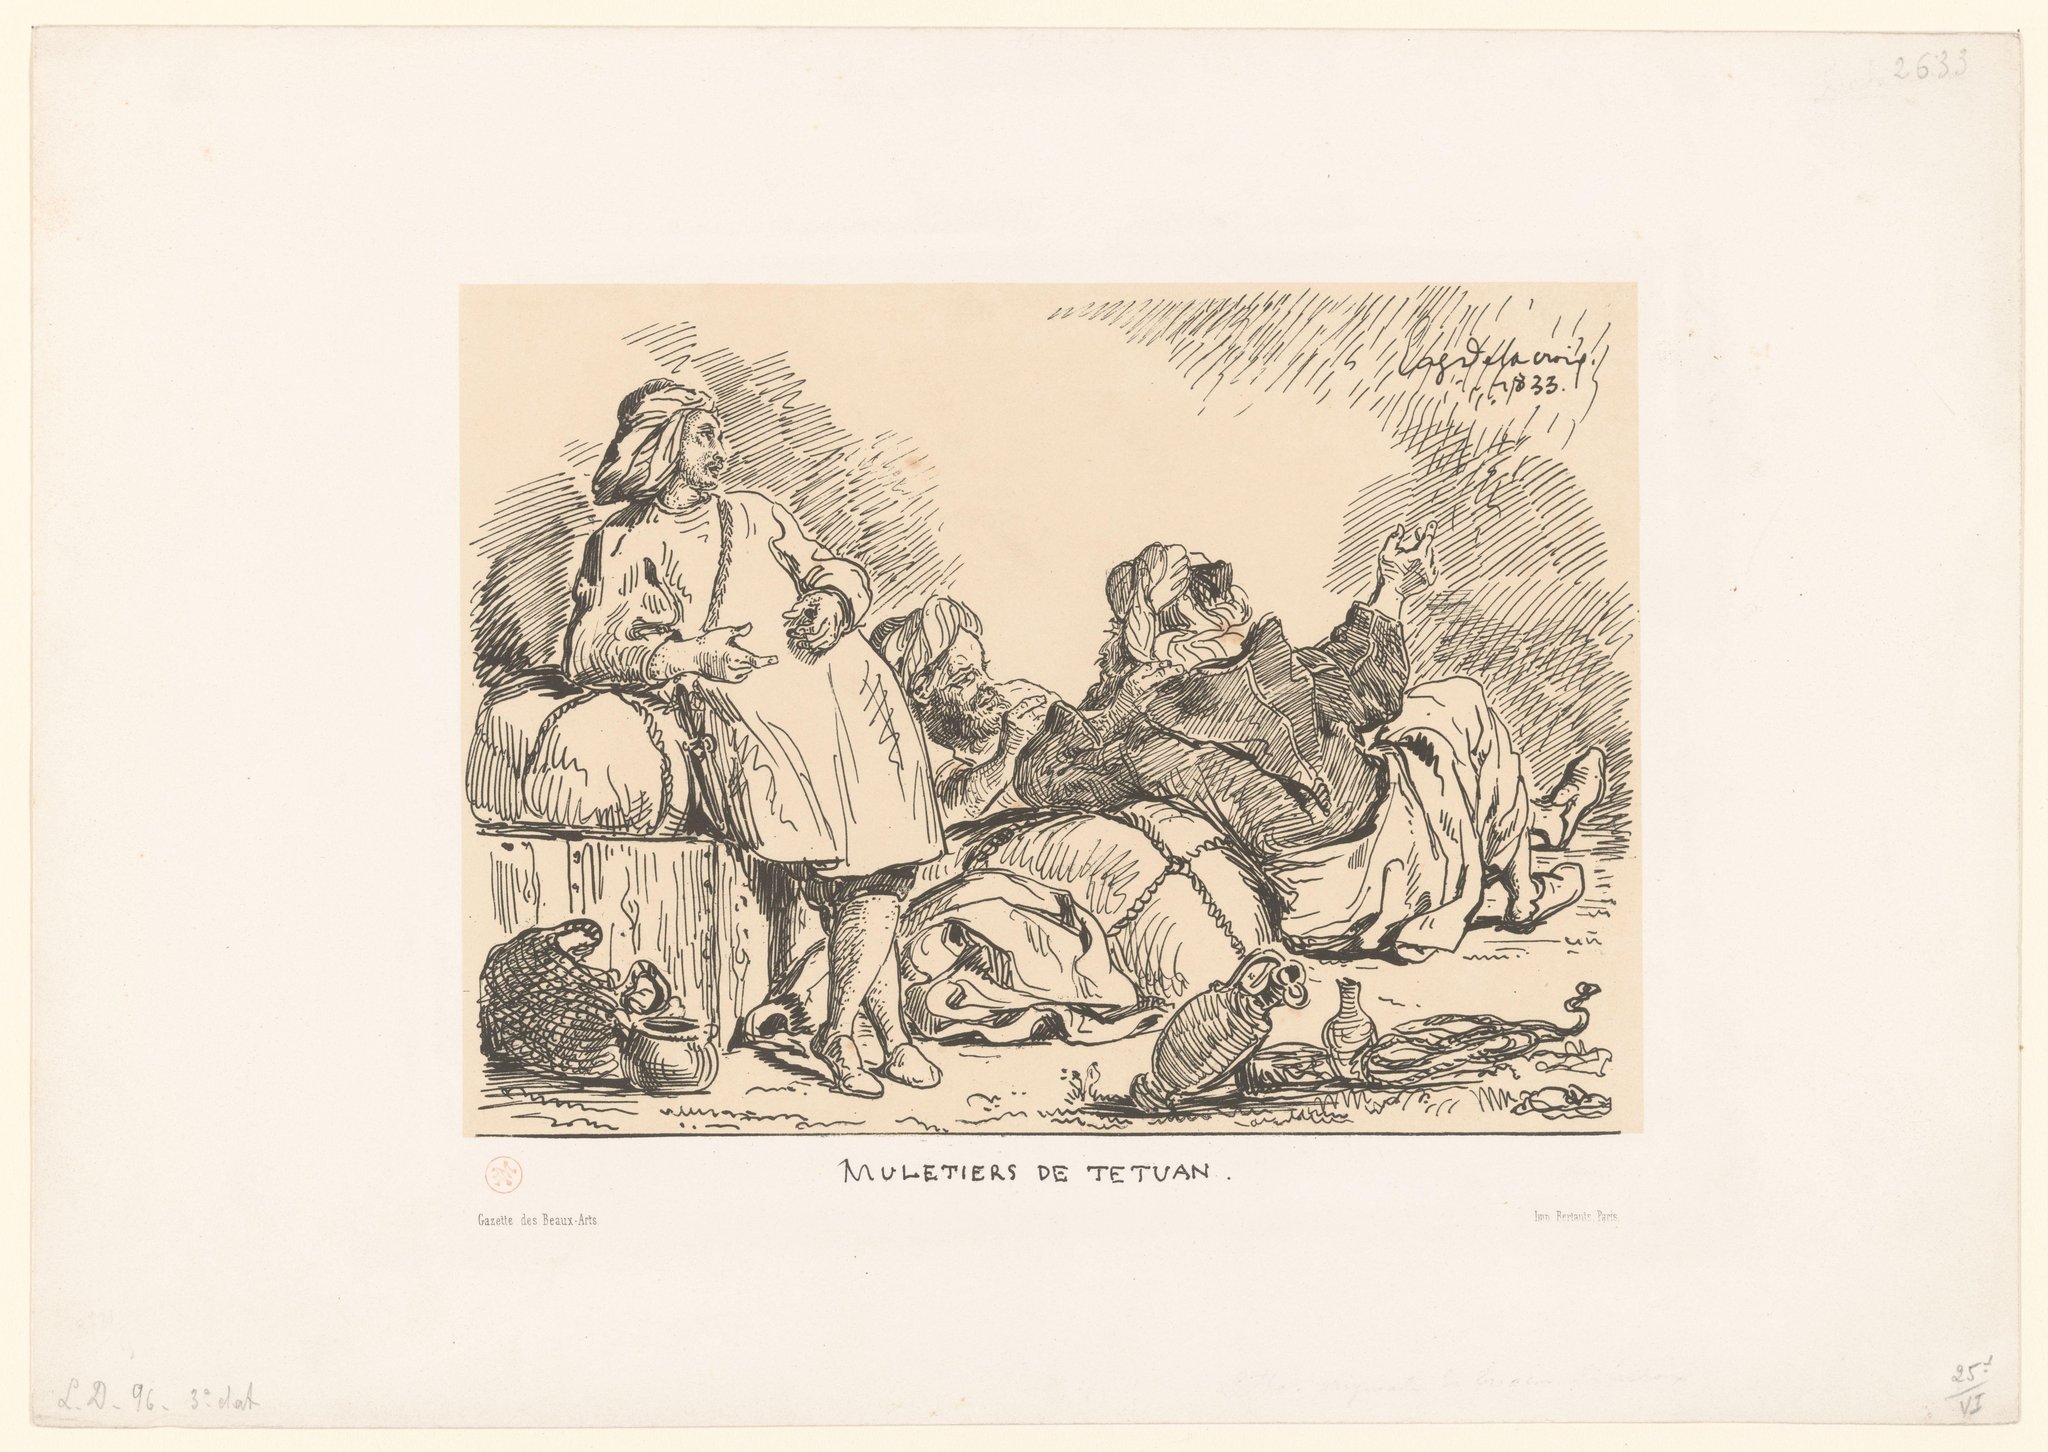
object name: print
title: Muletiers de Tetuan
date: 1833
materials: paper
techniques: pen lithography, tone lithography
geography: paris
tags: riding a horse, ass, or mule; rider, horseman, resting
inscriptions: collector's mark: Lugt 150b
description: Prent gebruikt voor: Gazette des Beaux-Arts 19 (1833).